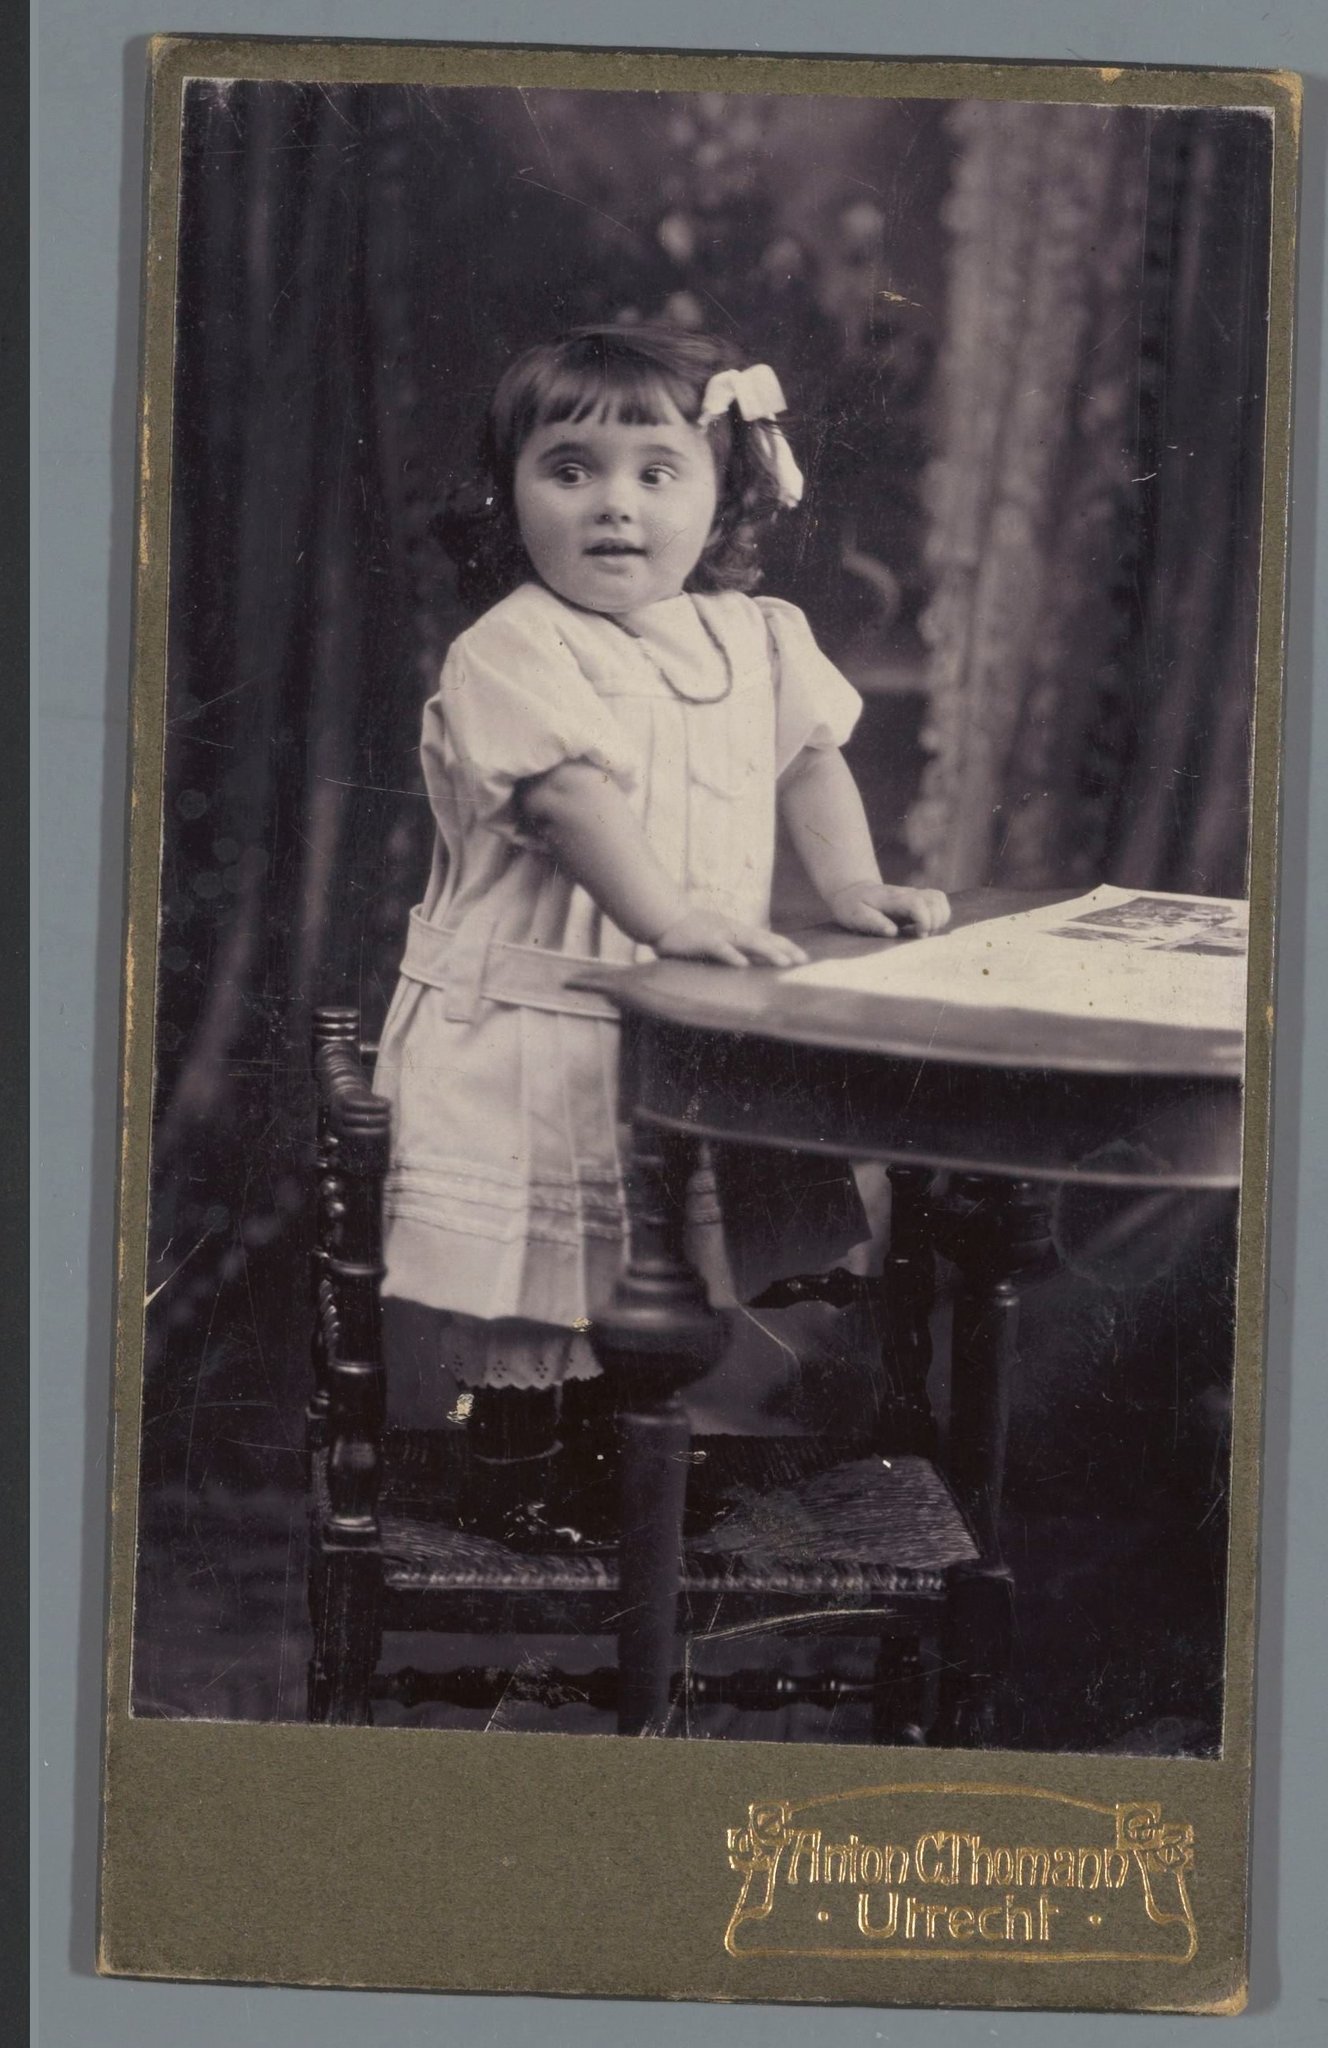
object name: photograph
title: Portret van een onbekend meisje, aangeduid als Mimi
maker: anton cornelis thomann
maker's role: fotograaf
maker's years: 1873-1946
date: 1909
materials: cardboard, photographic support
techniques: gelatin silver print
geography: utrecht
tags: historical persons, girl (child between toddler and youth)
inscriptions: inscription: ‘ANTON/ C THOMANN/ Fotograaf/ UTRECHT/ TELF. 893./ ONDERSCHEIDINGEN IN BINNEN/ EN BUITENLAND/ Prager & Loida Berlin 27608’, inscription: ‘Mimi oud 2 jaar/ [...]/ 1909’